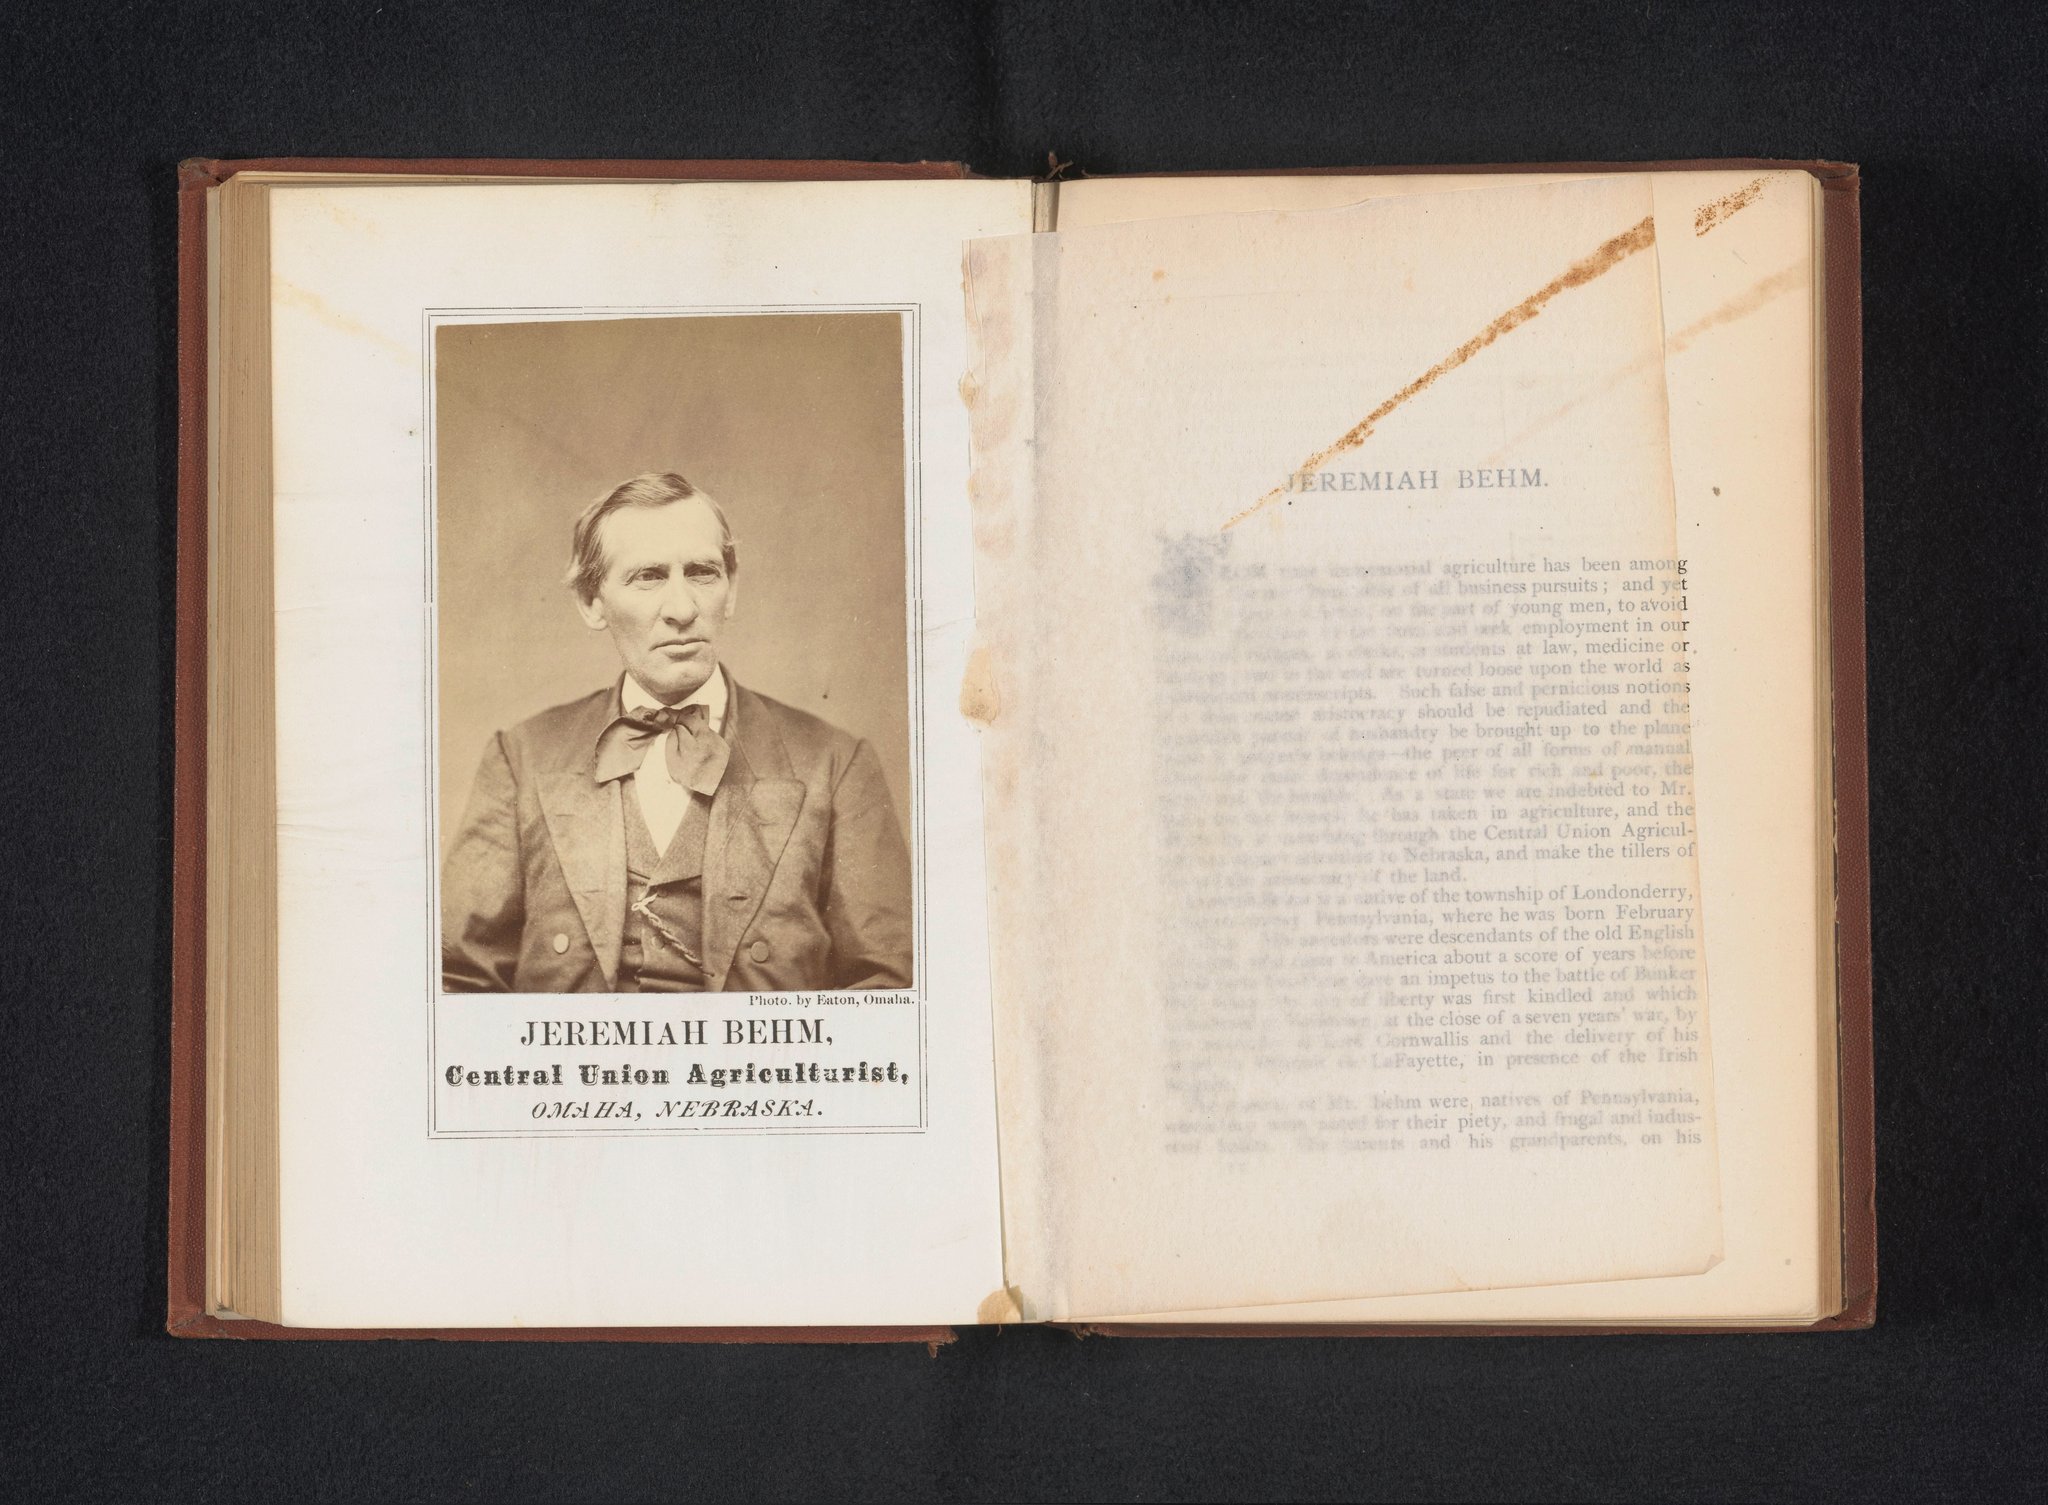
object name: photograph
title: Portret van Jeremiah Behm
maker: edric l. eaton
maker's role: fotograaf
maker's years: 1835-1890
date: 1866-1871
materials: photographic support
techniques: albumen print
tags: historical persons, politician, e.g. party leader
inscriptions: inscription: ‘Central Union Agricultarist, Omaha, Nebraska’